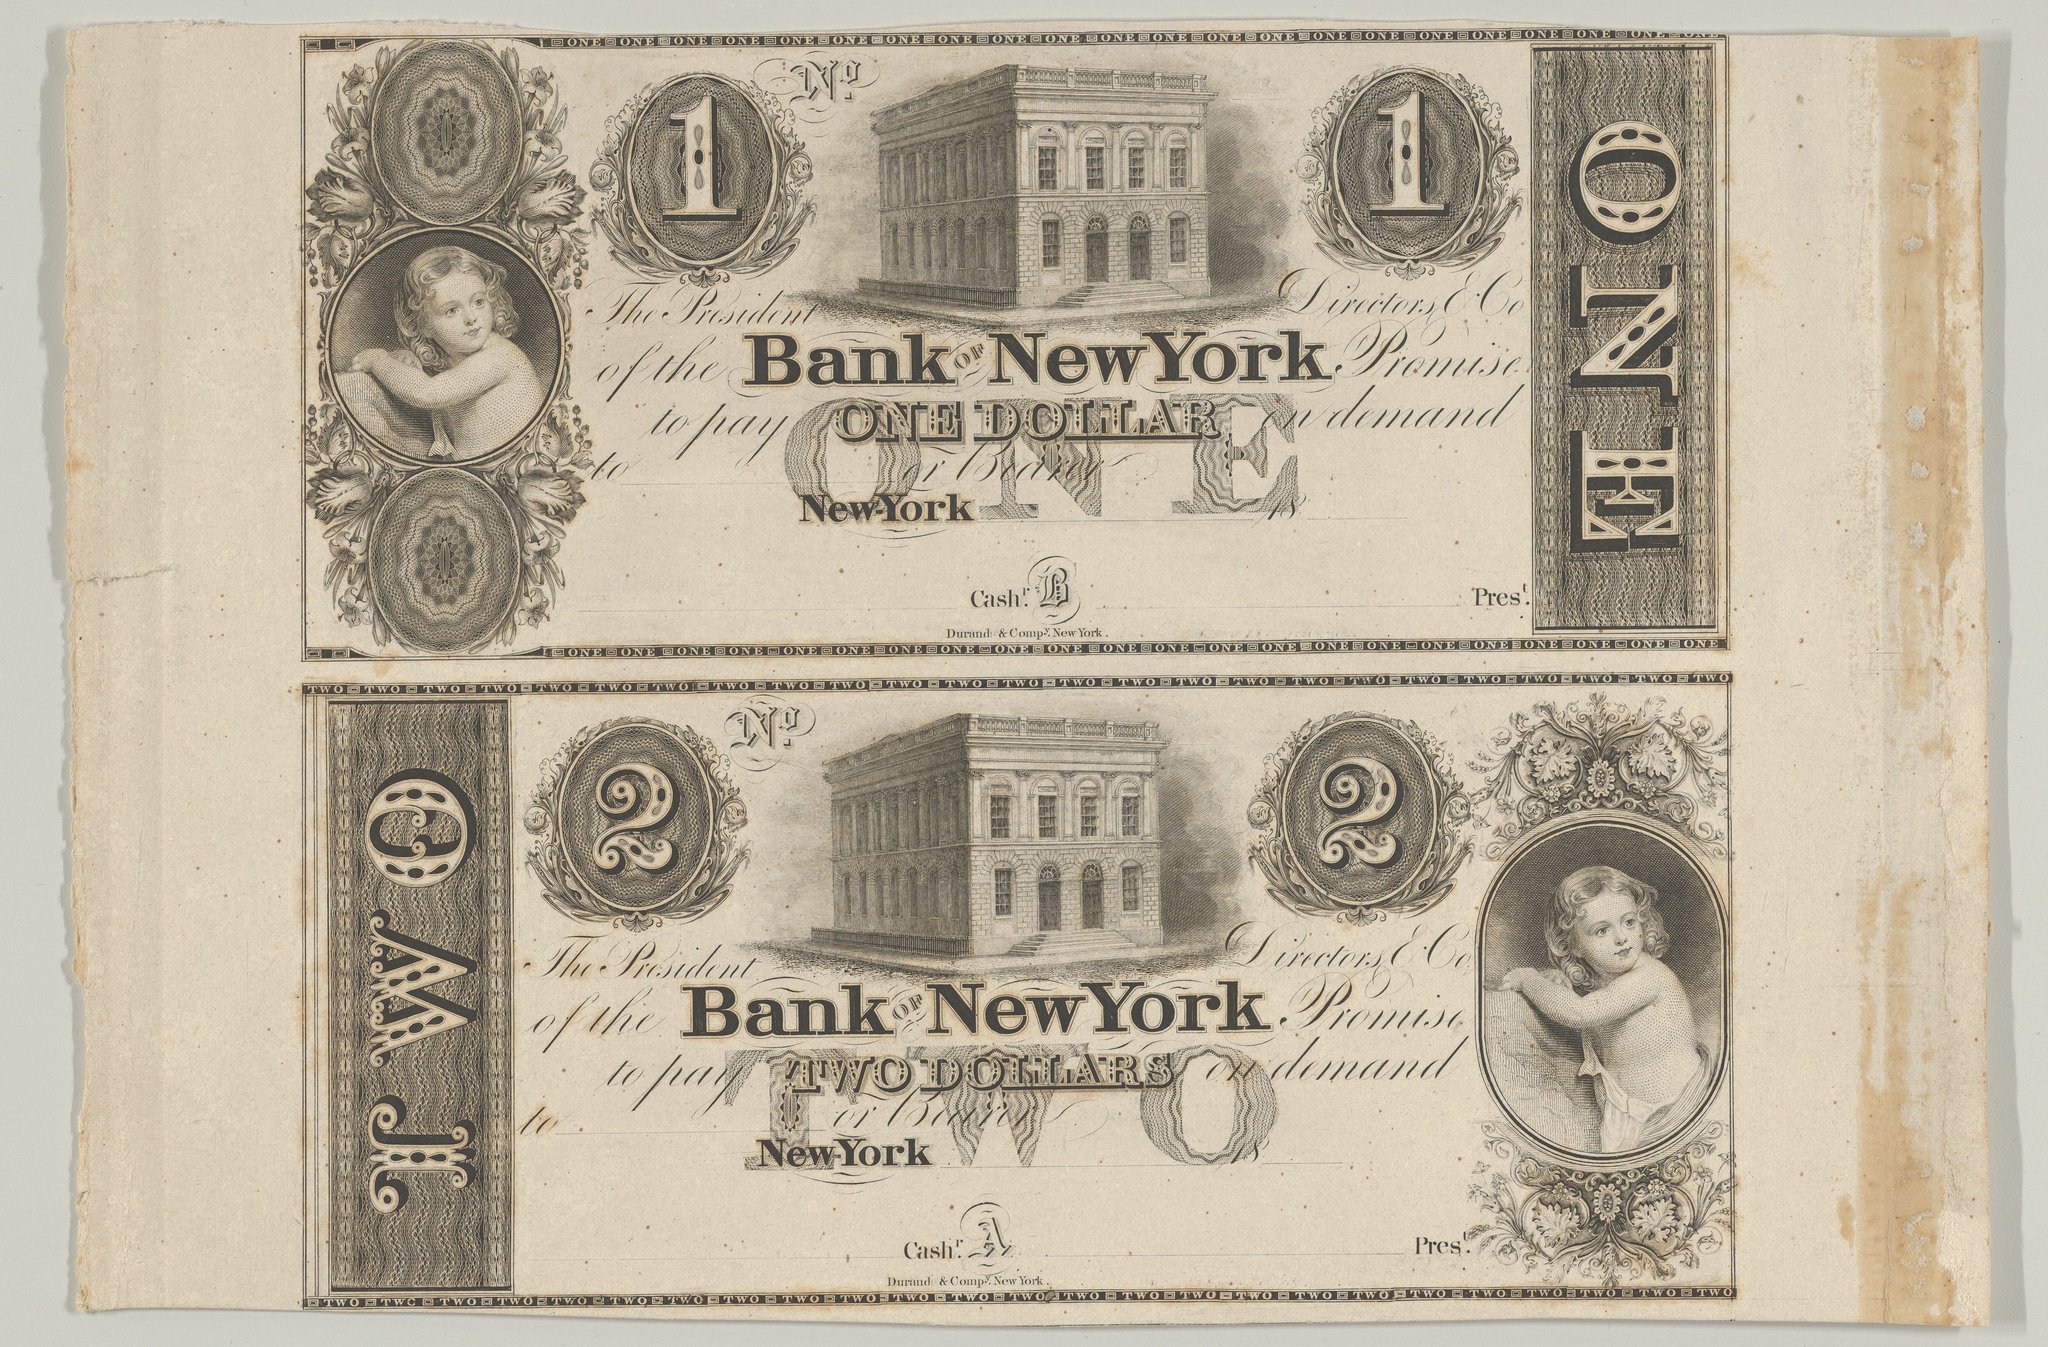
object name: print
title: Proofs of Bank of New York One Dollar Bill and Two Dollar Bill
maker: asher brown durand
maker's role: artist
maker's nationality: american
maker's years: 1796-1886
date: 1824-1837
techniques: engraving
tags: money